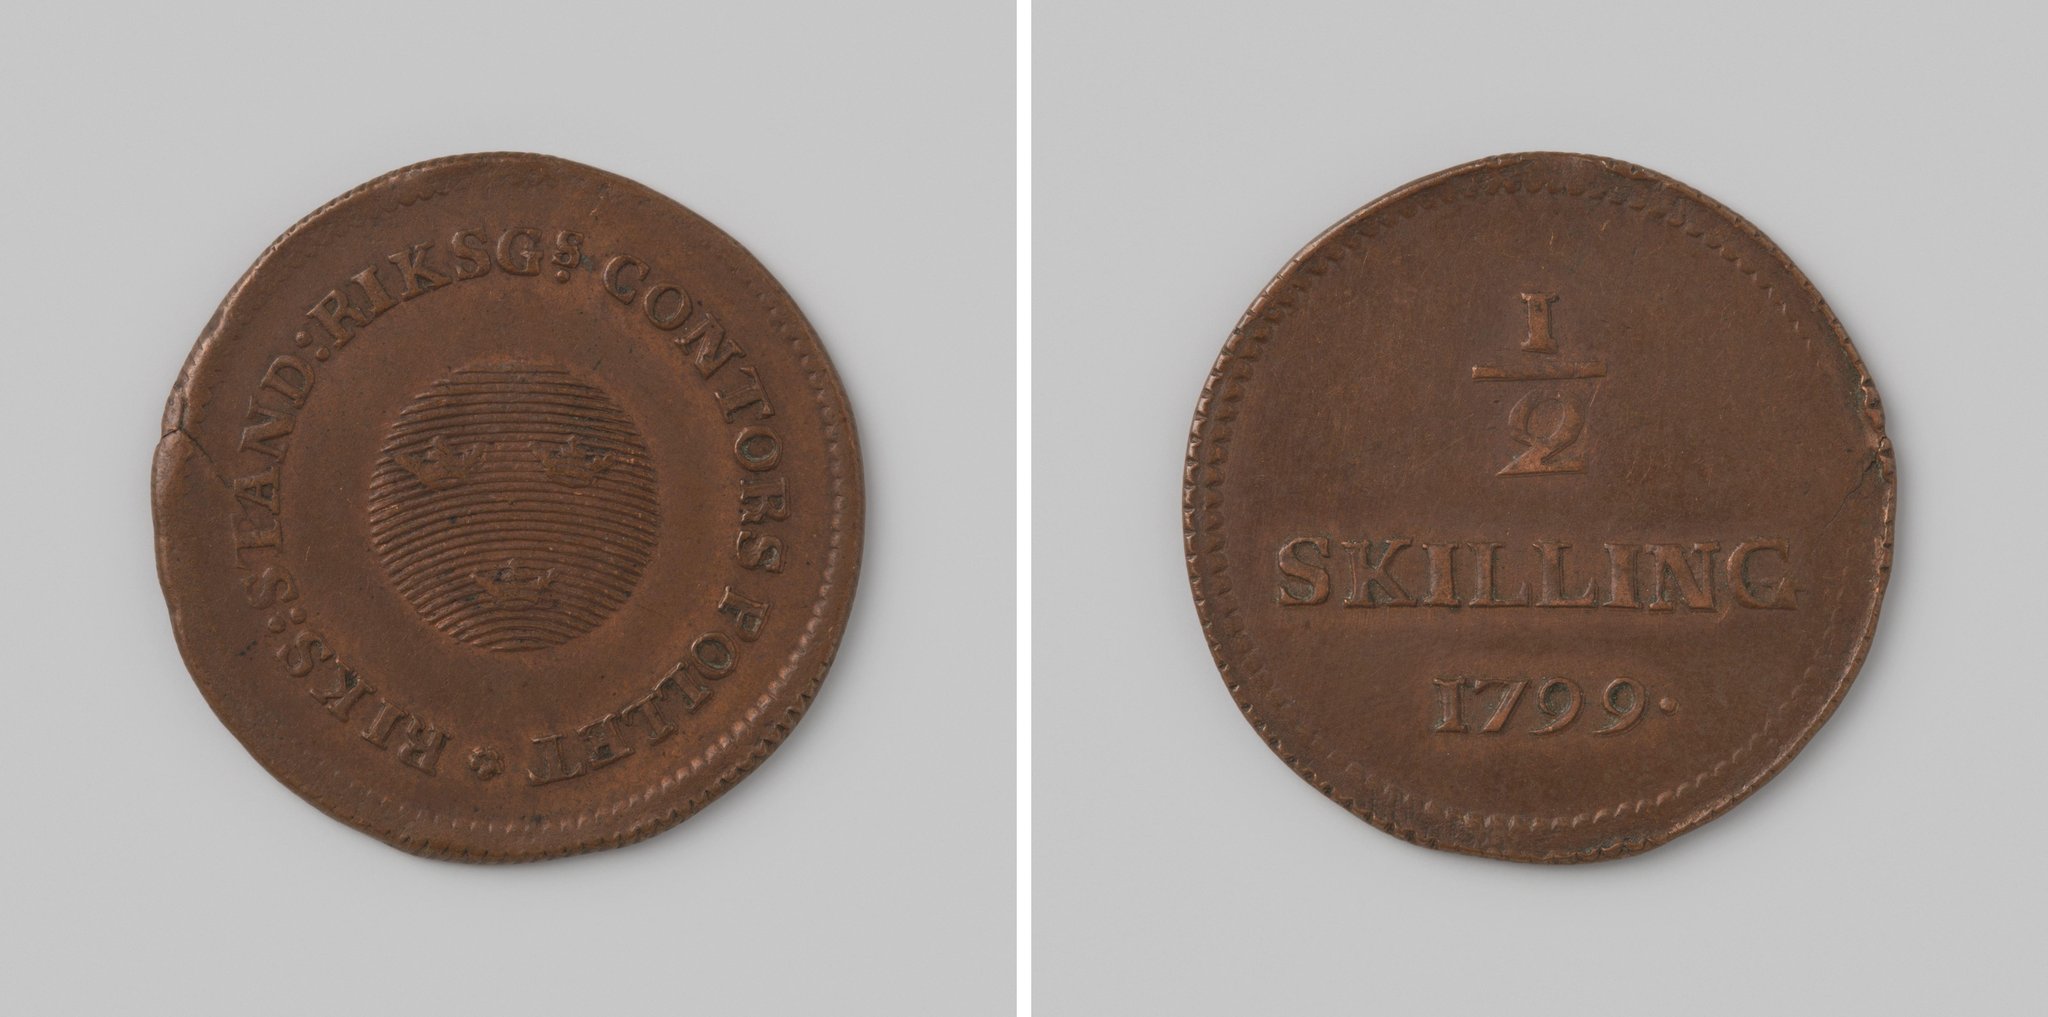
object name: coin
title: Zweden, Riksgälds Contor, ½ skilling,1799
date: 1799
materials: copper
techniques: striking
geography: slot rörstrand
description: Koperen munt. Voorzijde: rond wapenschild van Zweden. Keerzijde: waarde-aanduiding in twee regels. Daaronder jaartal. Kabelrand.